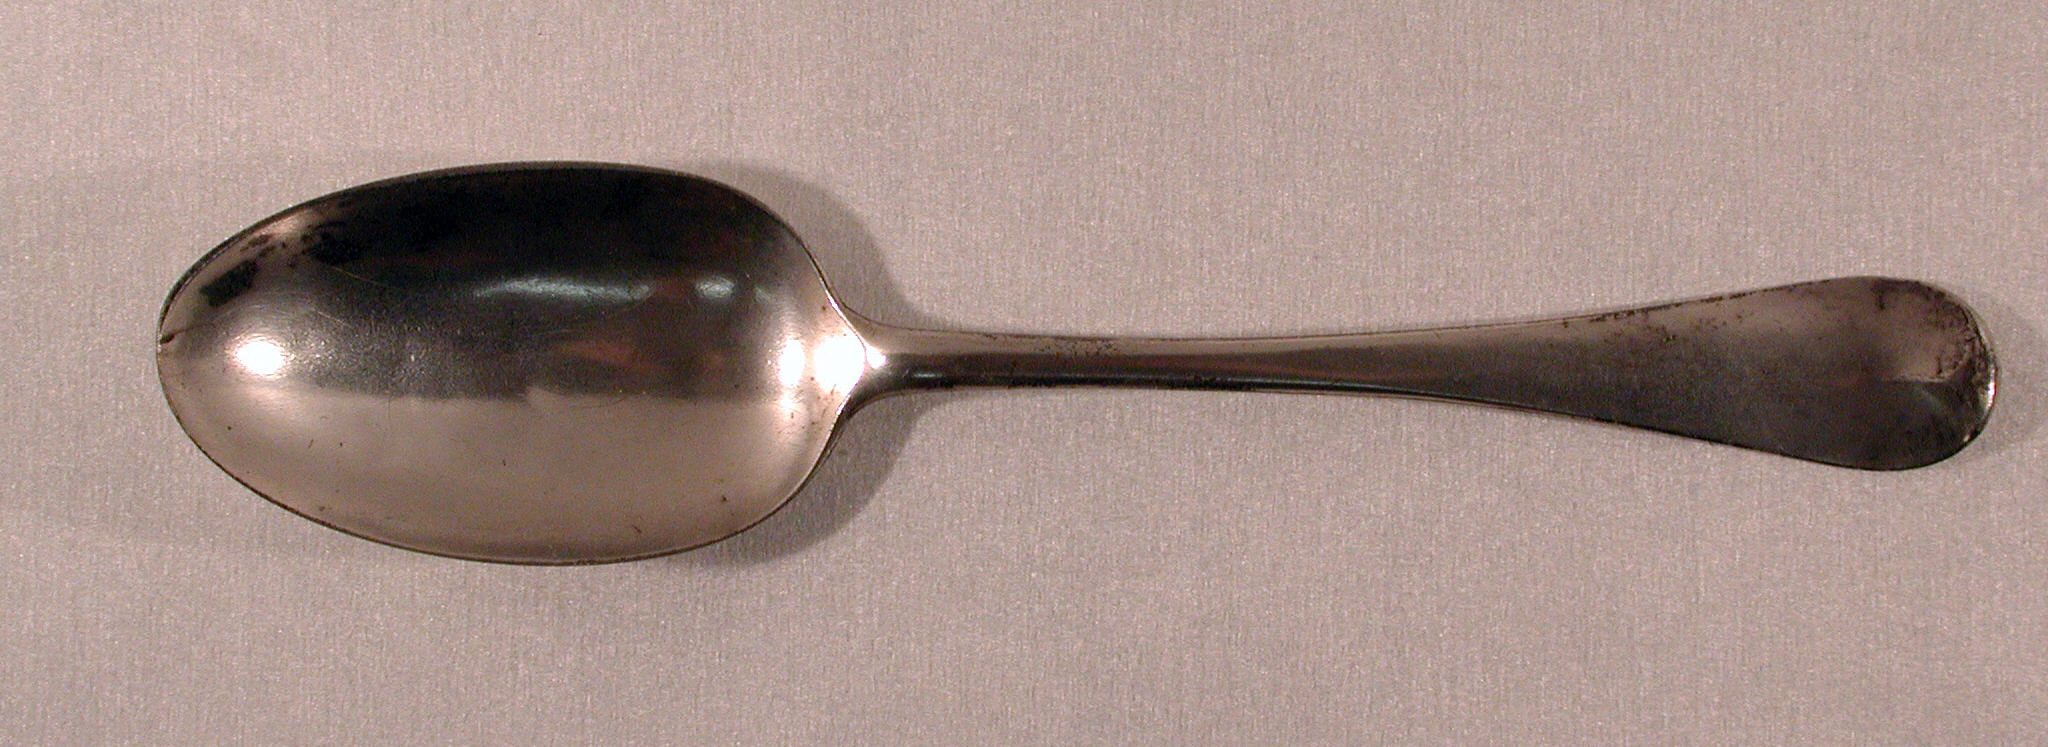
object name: dessert spoon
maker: robert pertt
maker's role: maker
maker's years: 1738-1755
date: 1747-1748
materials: silver